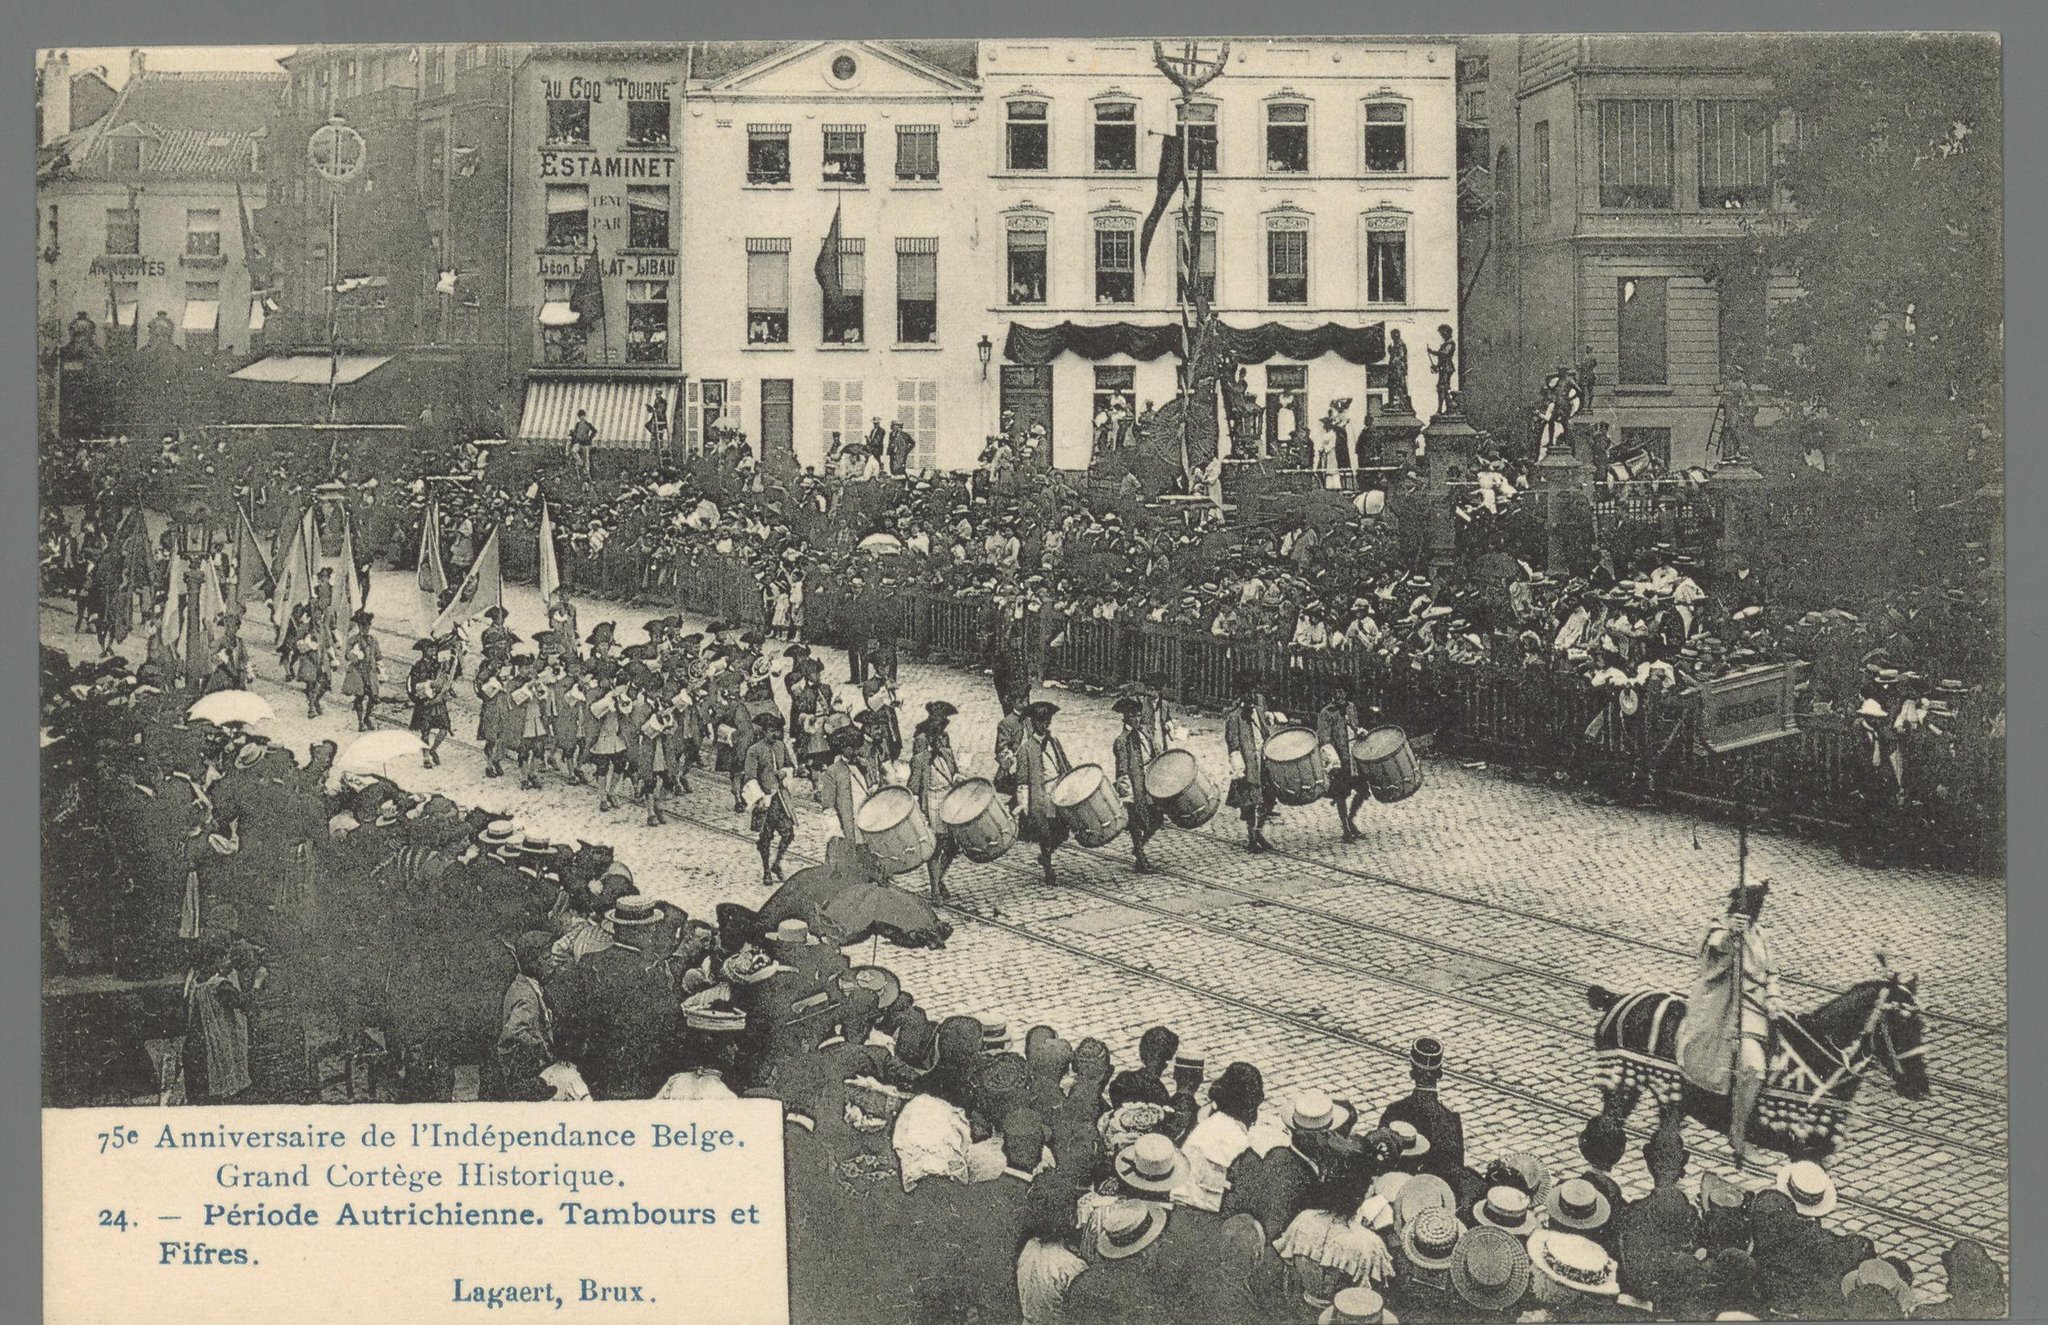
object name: ansichtkaart, prentbriefkaart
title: Période Autrichienne. Tambours et Fifres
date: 1905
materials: cardboard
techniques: photograph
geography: brussels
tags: city-view, and landscape with man-made constructions (+ city(-scape) with figures, staffage), periodic celebrations, popular feasts, brussels